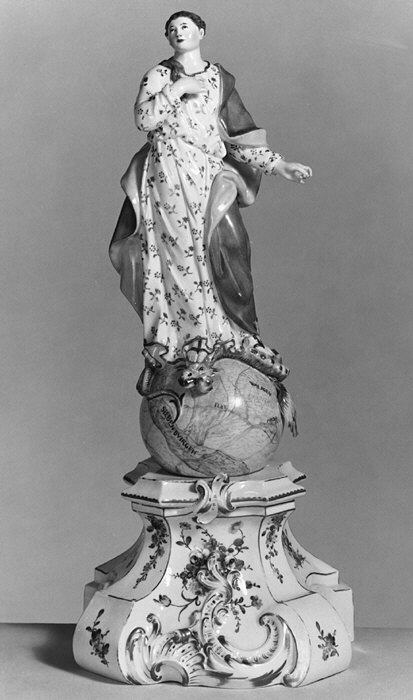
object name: figure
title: Maria Immaculata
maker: fulda pottery and porcelain manufactory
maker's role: manufactory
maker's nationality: german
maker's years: 1764-1789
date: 1770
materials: hard paste porcelain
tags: flowers,leaves,virgin mary,globes